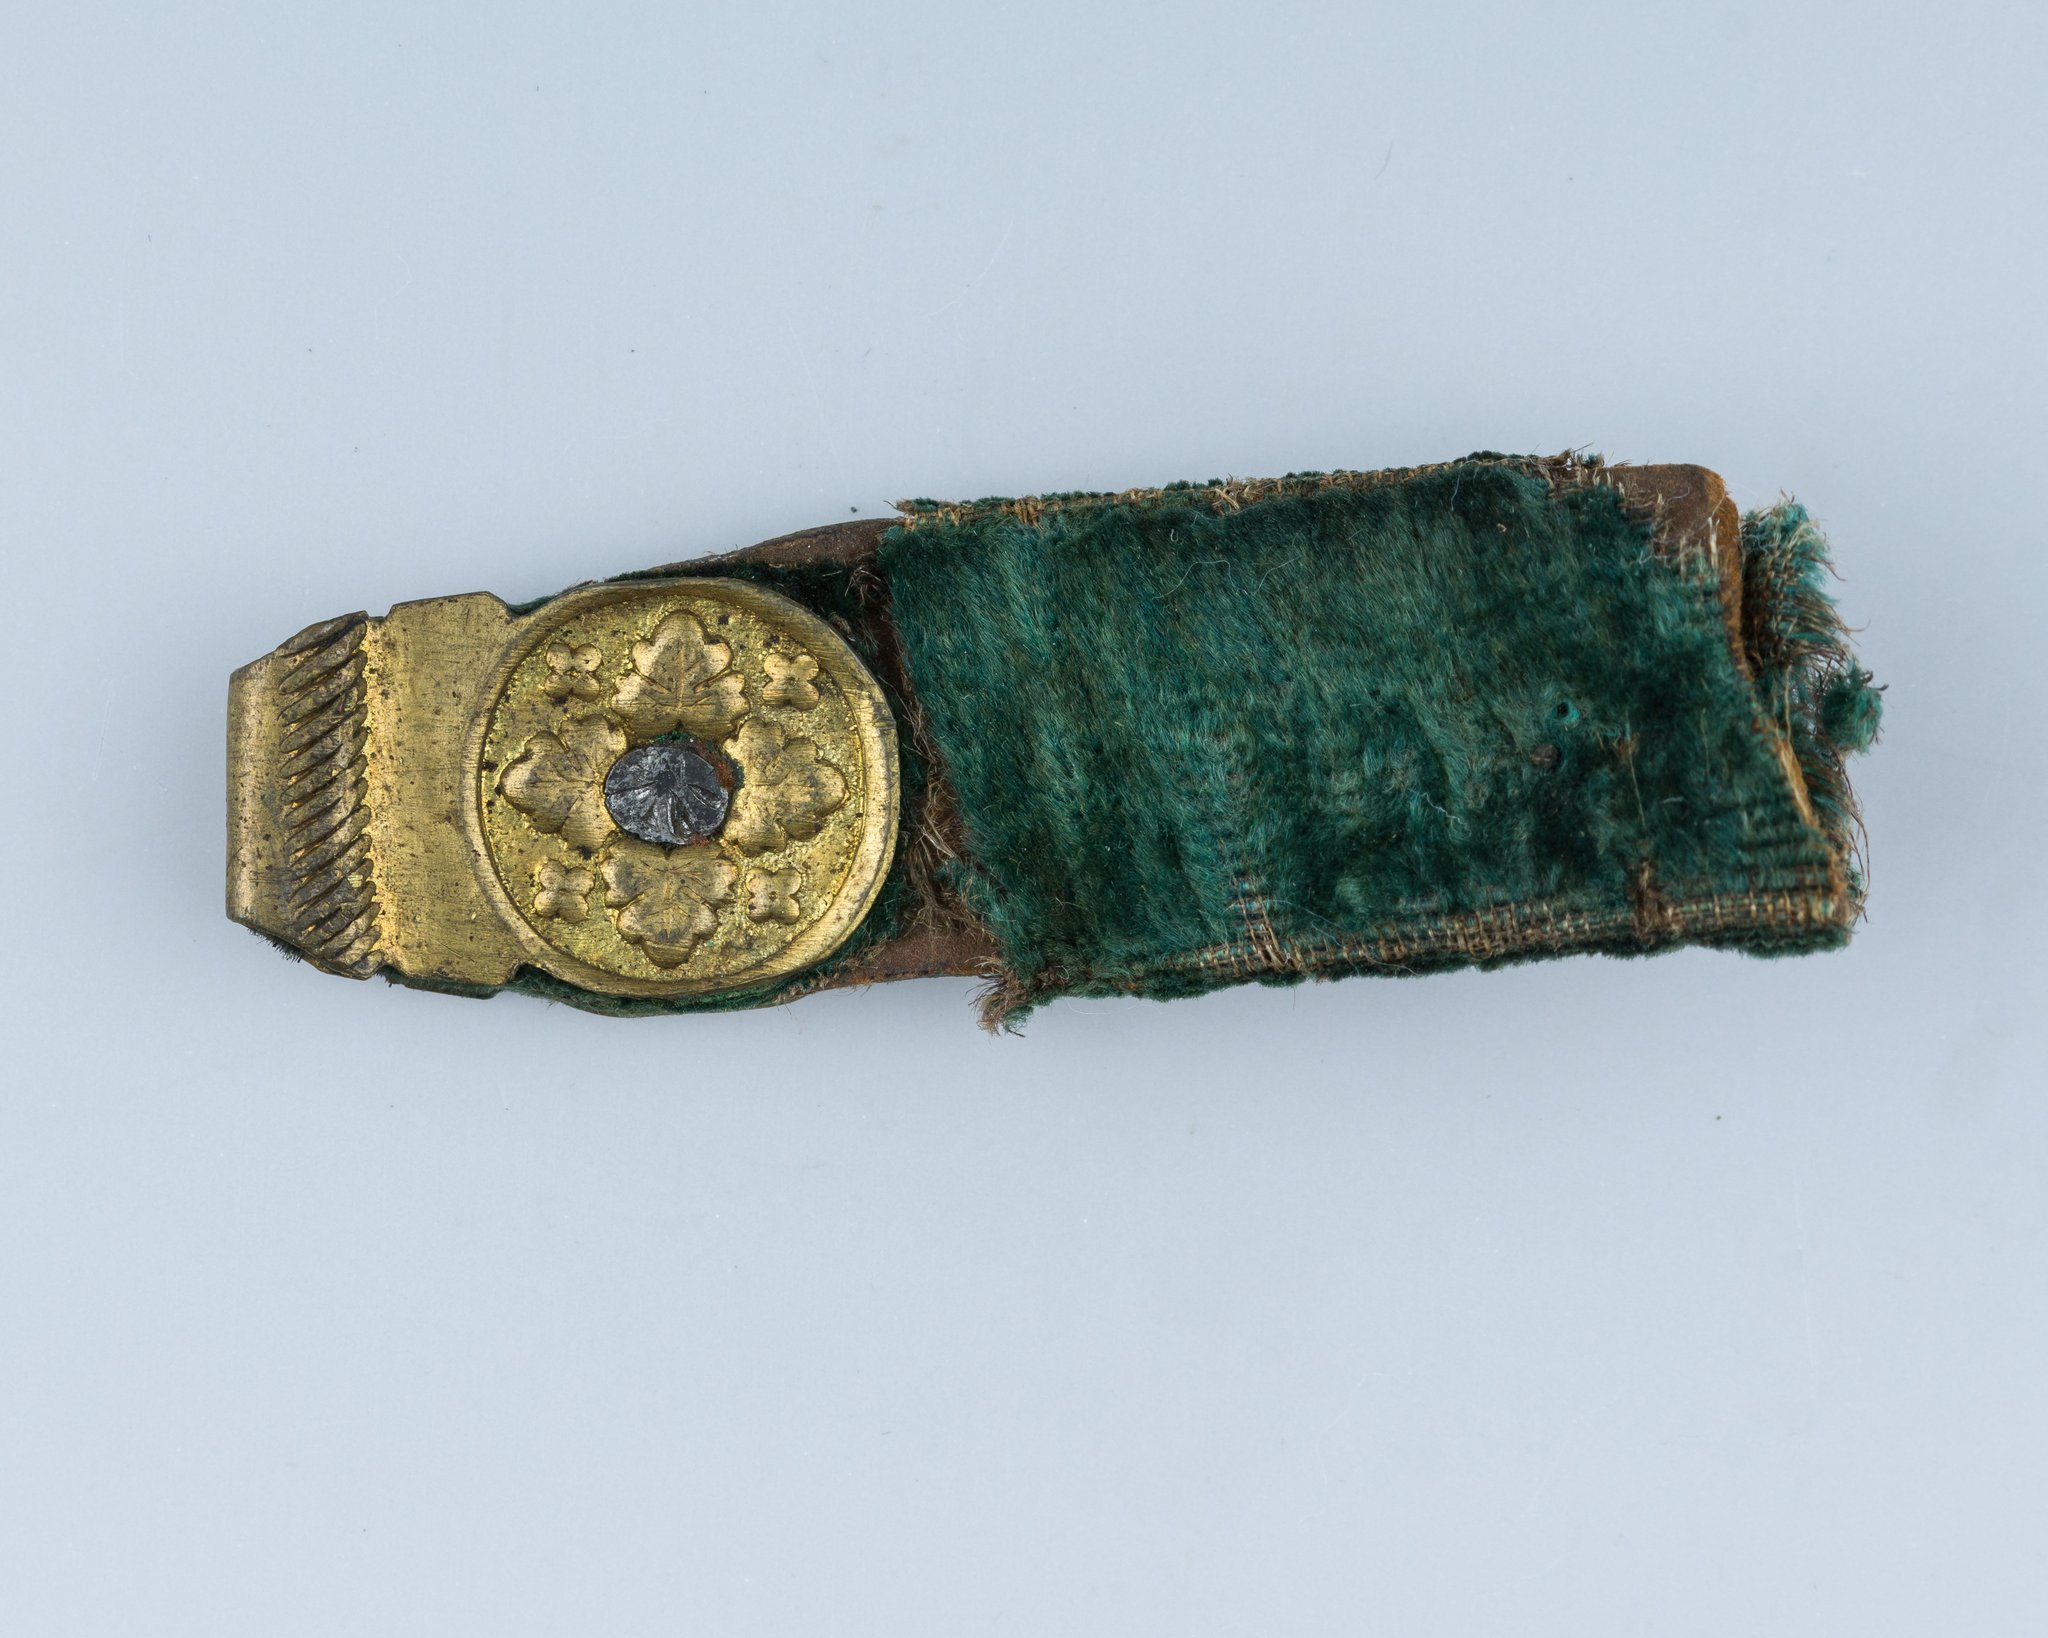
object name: mordant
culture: hungarian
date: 1506-1525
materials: brass, velvet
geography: hungary